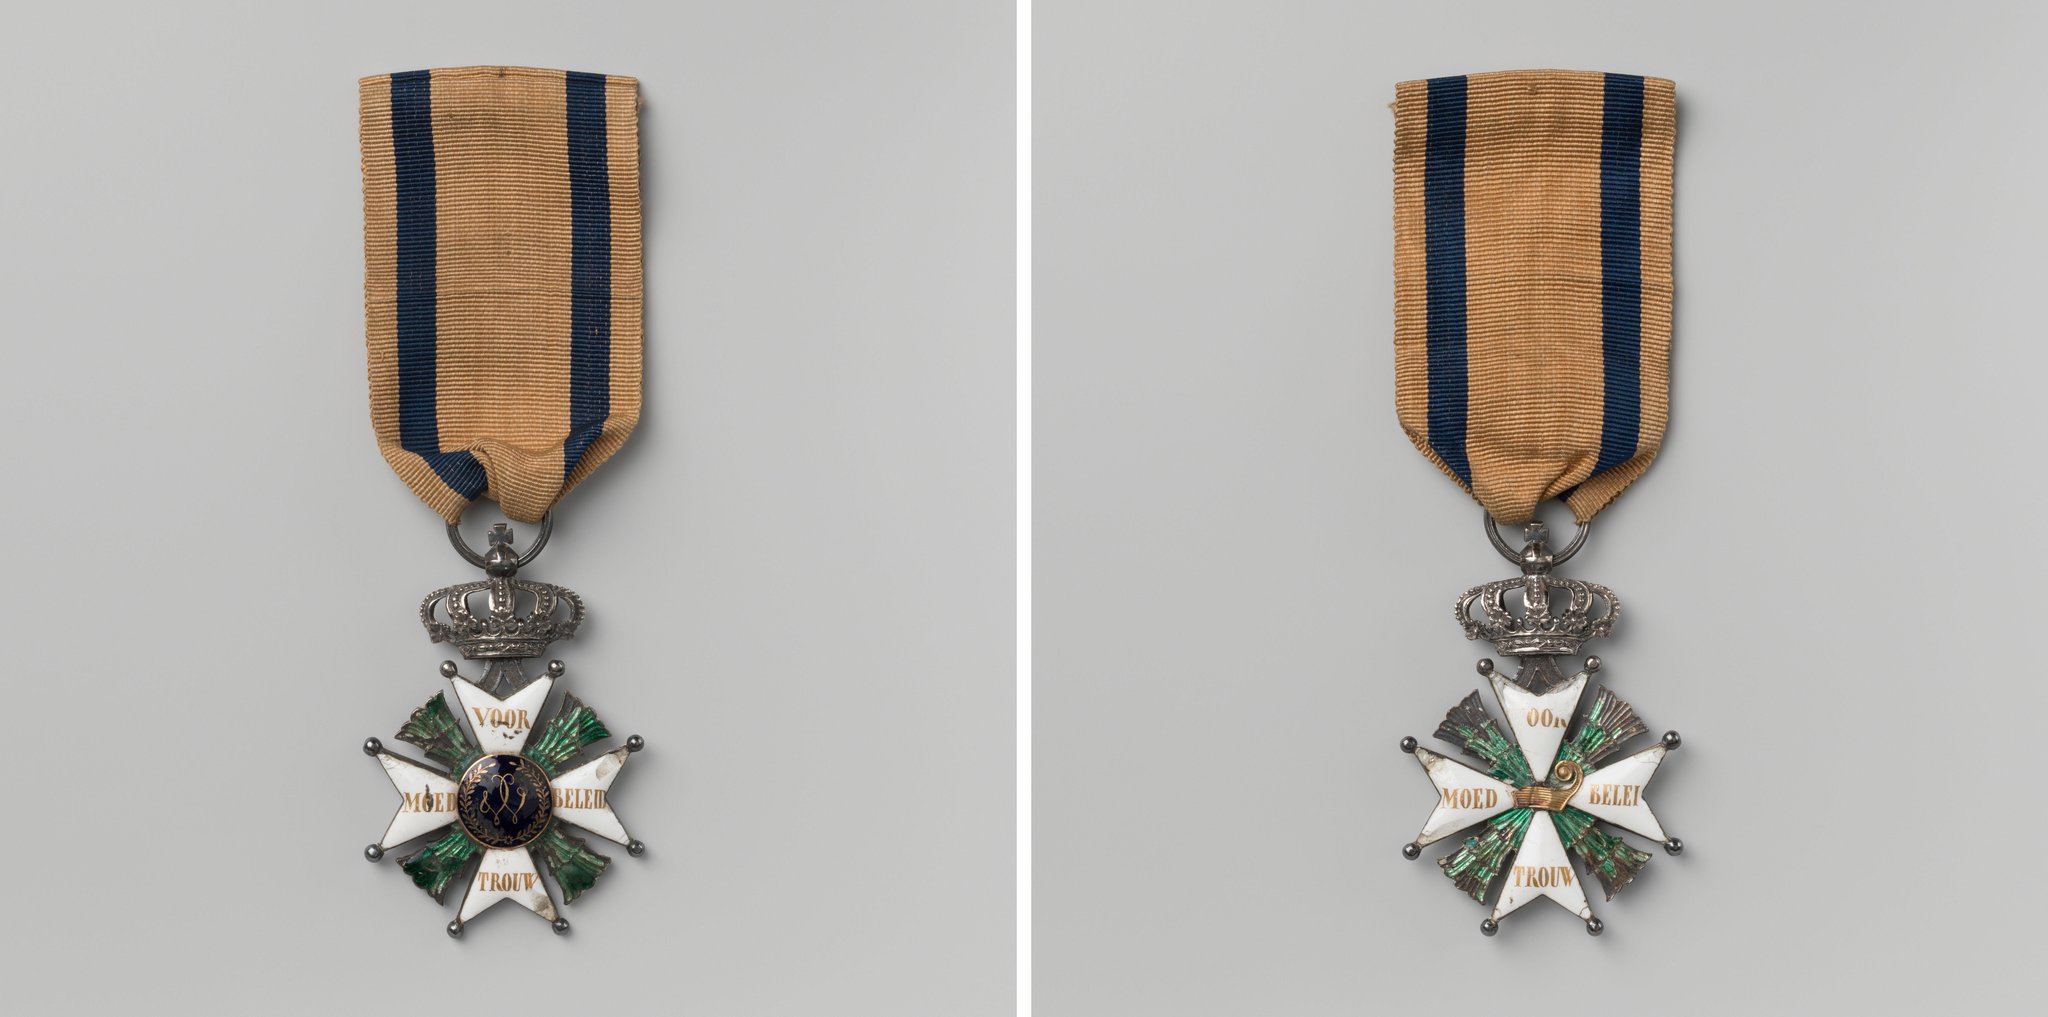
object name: onderscheidingsteken, onderscheiding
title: Militaire Willemsorde, ridder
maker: Anonymous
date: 1815-1900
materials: silver, textile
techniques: striking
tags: netherlands